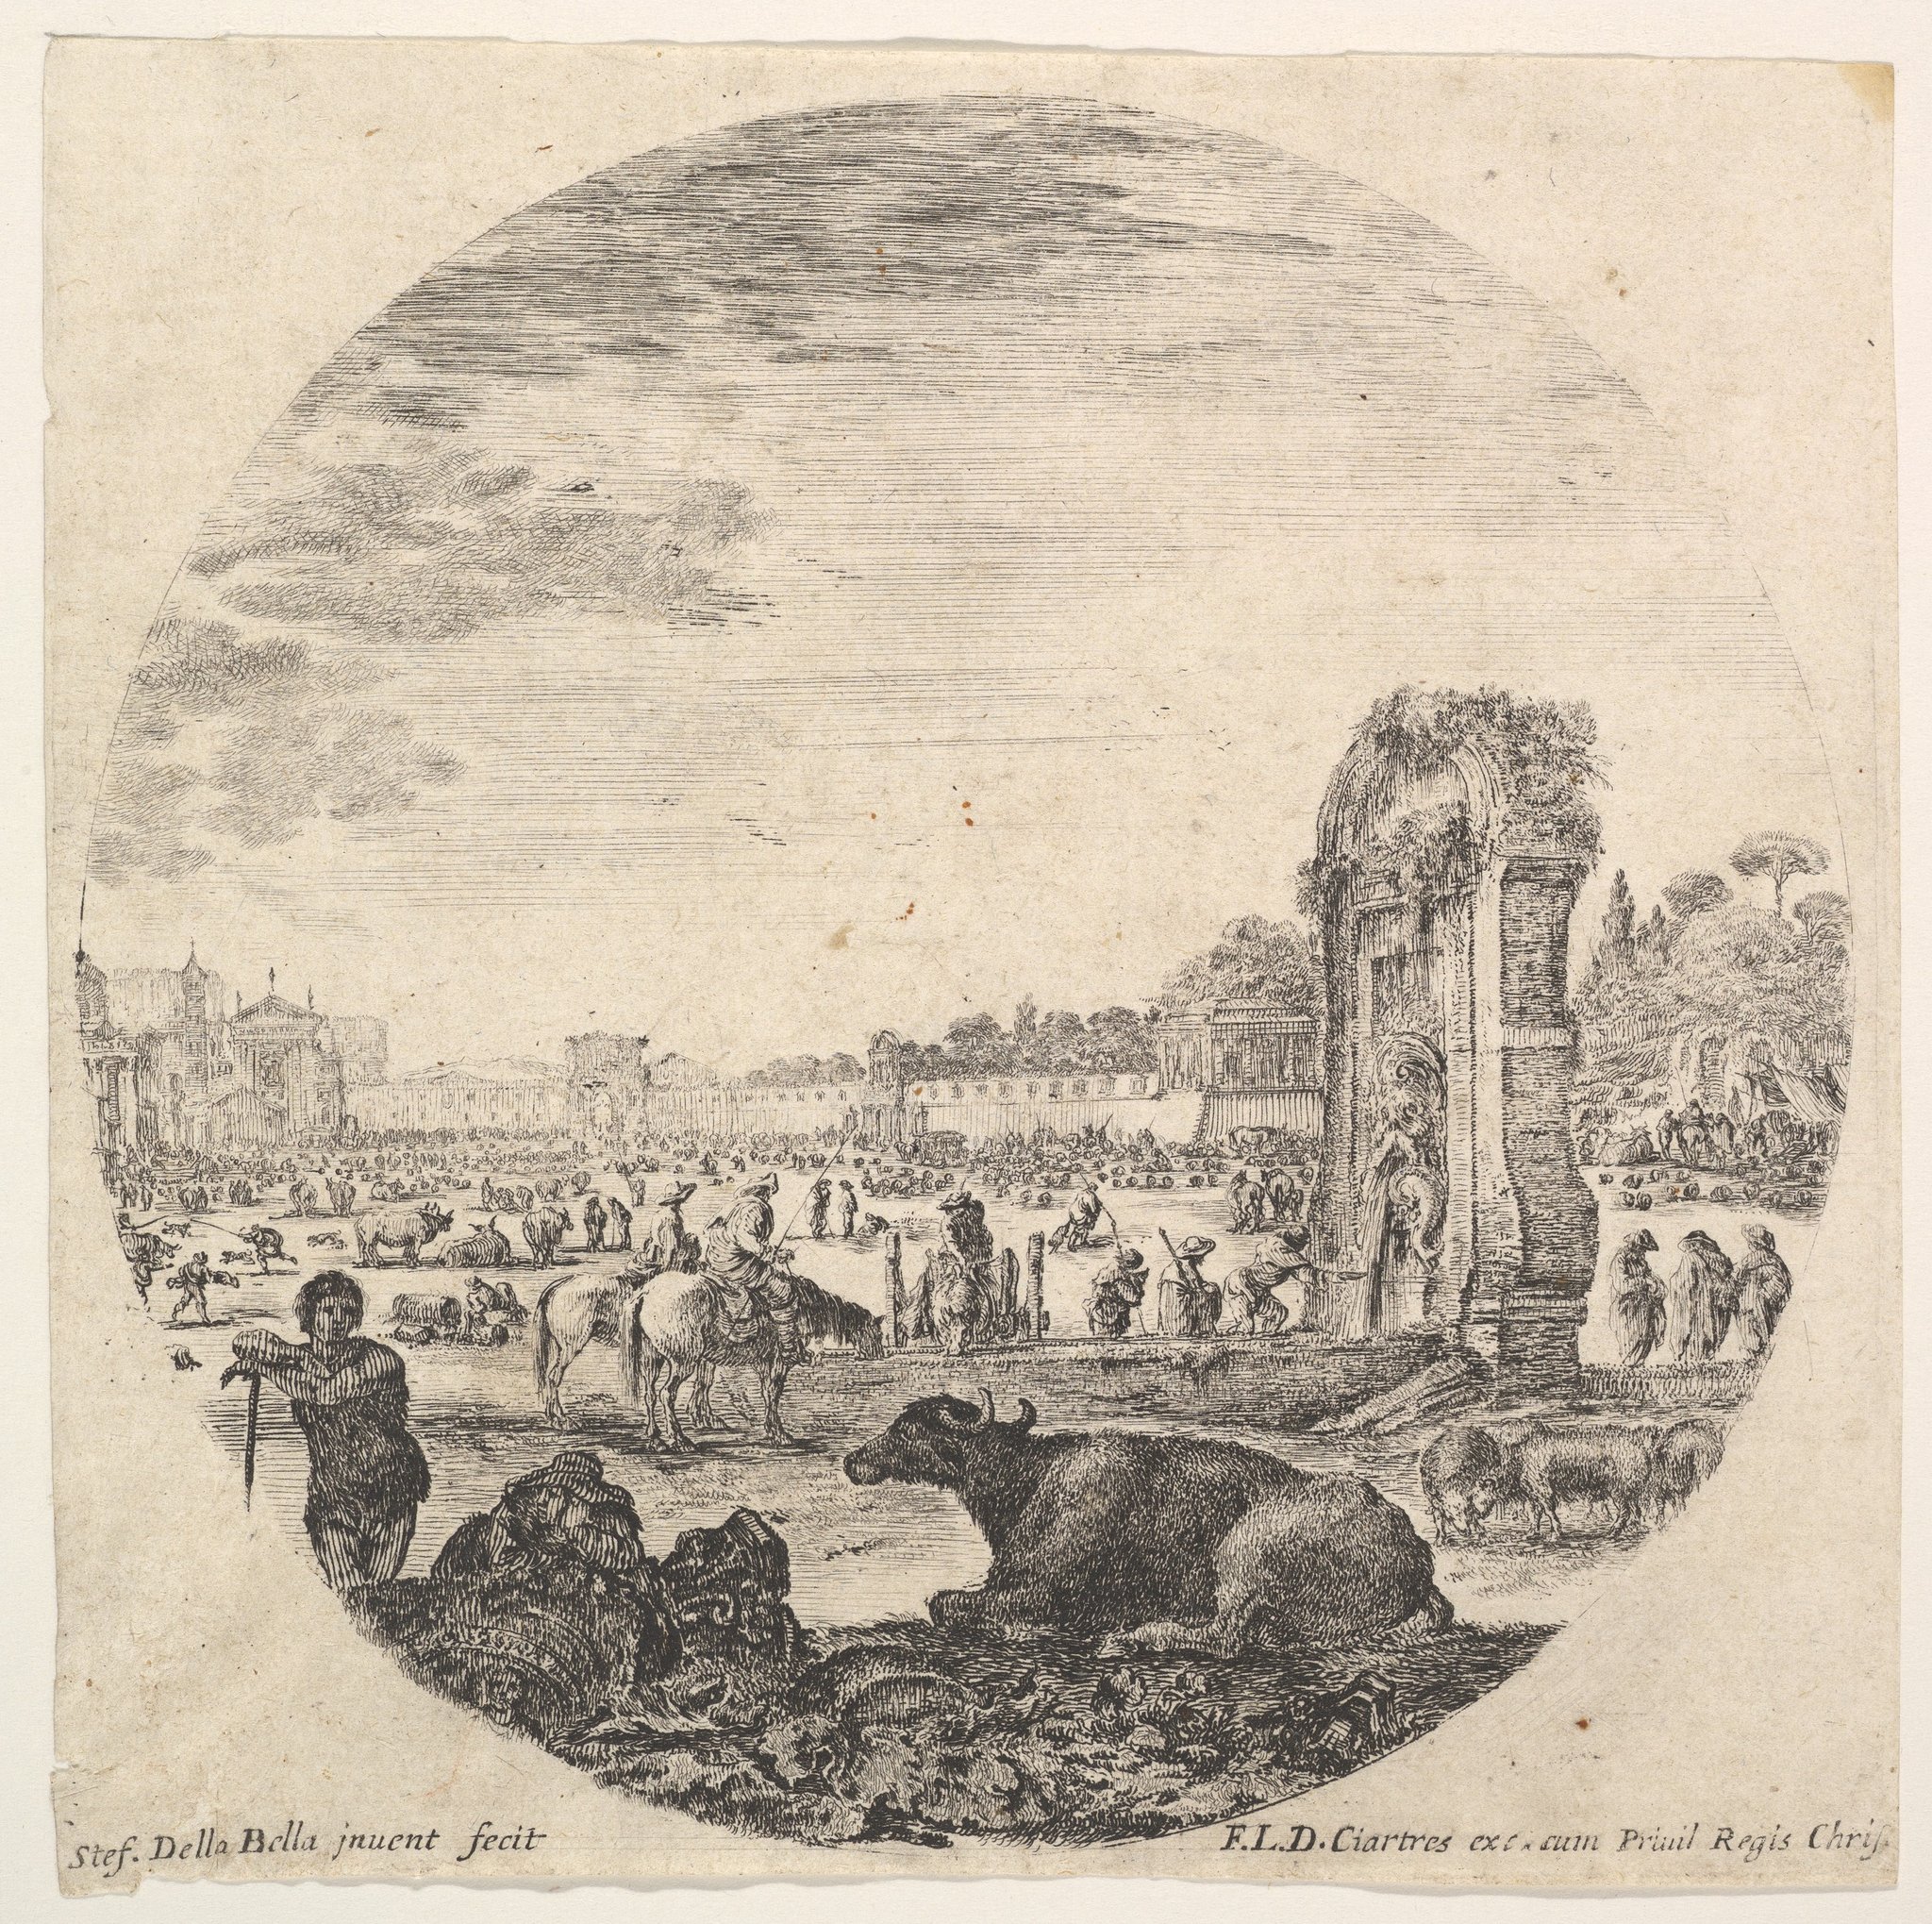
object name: print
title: Plate 2: Campo Vaccino, a buffalo and two shepherds in center, the Fontanone, various animals and people in the background, from "Roman landscapes and ruins" (Paysages et ruines de Rome)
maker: stefano della bella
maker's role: artist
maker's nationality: italian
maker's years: 1610-1664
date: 1643-1648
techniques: etching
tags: ruins,men,buffalos,shepherds